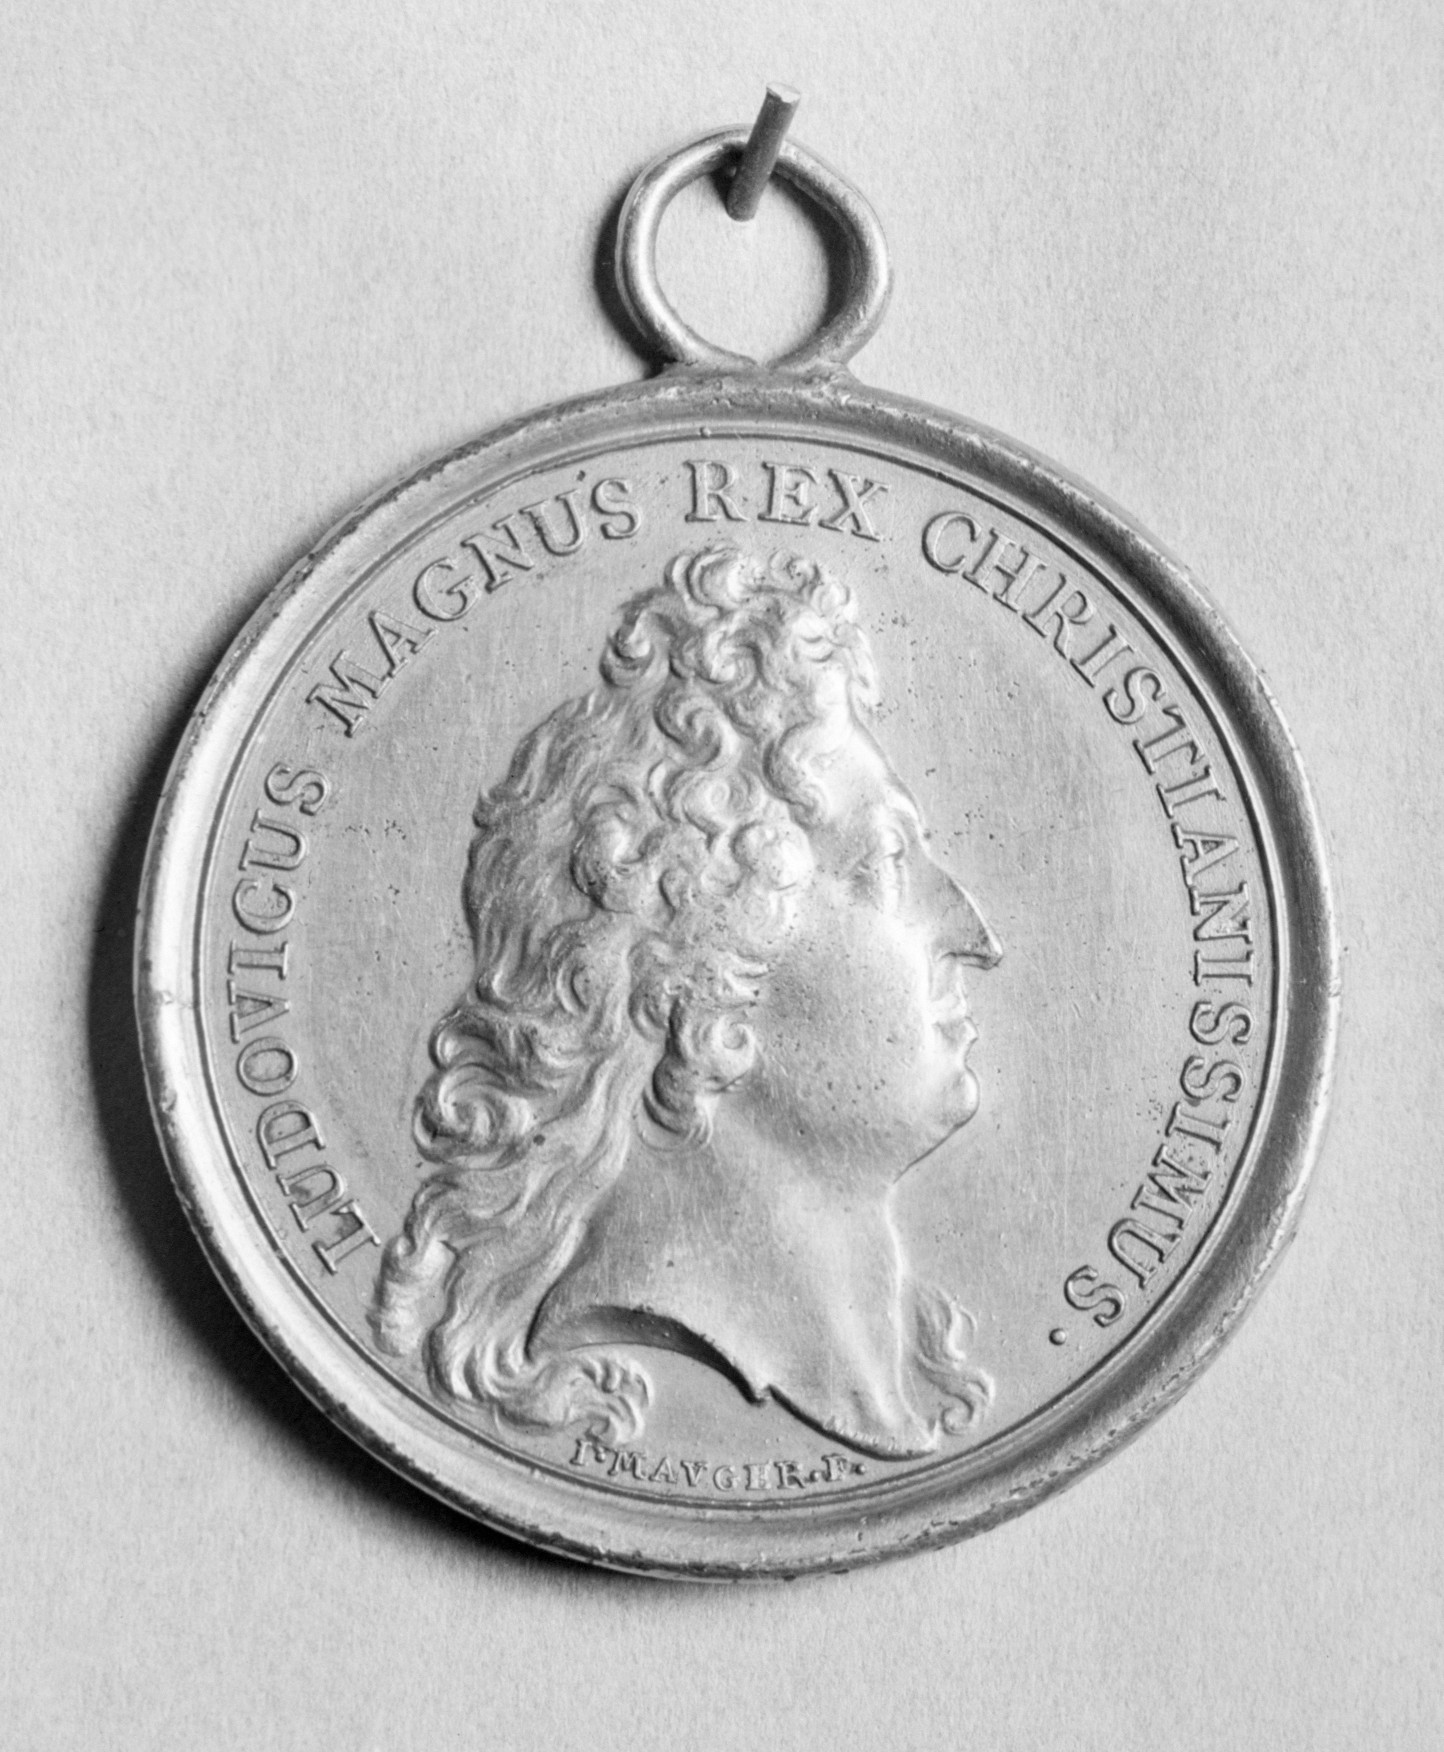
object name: medal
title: Louis XIV (b. 1638, r. 1643–1715)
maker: jean mauger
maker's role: medailleur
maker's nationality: french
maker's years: 1648-1722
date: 1674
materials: gilt bronze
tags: louis xiv,profiles